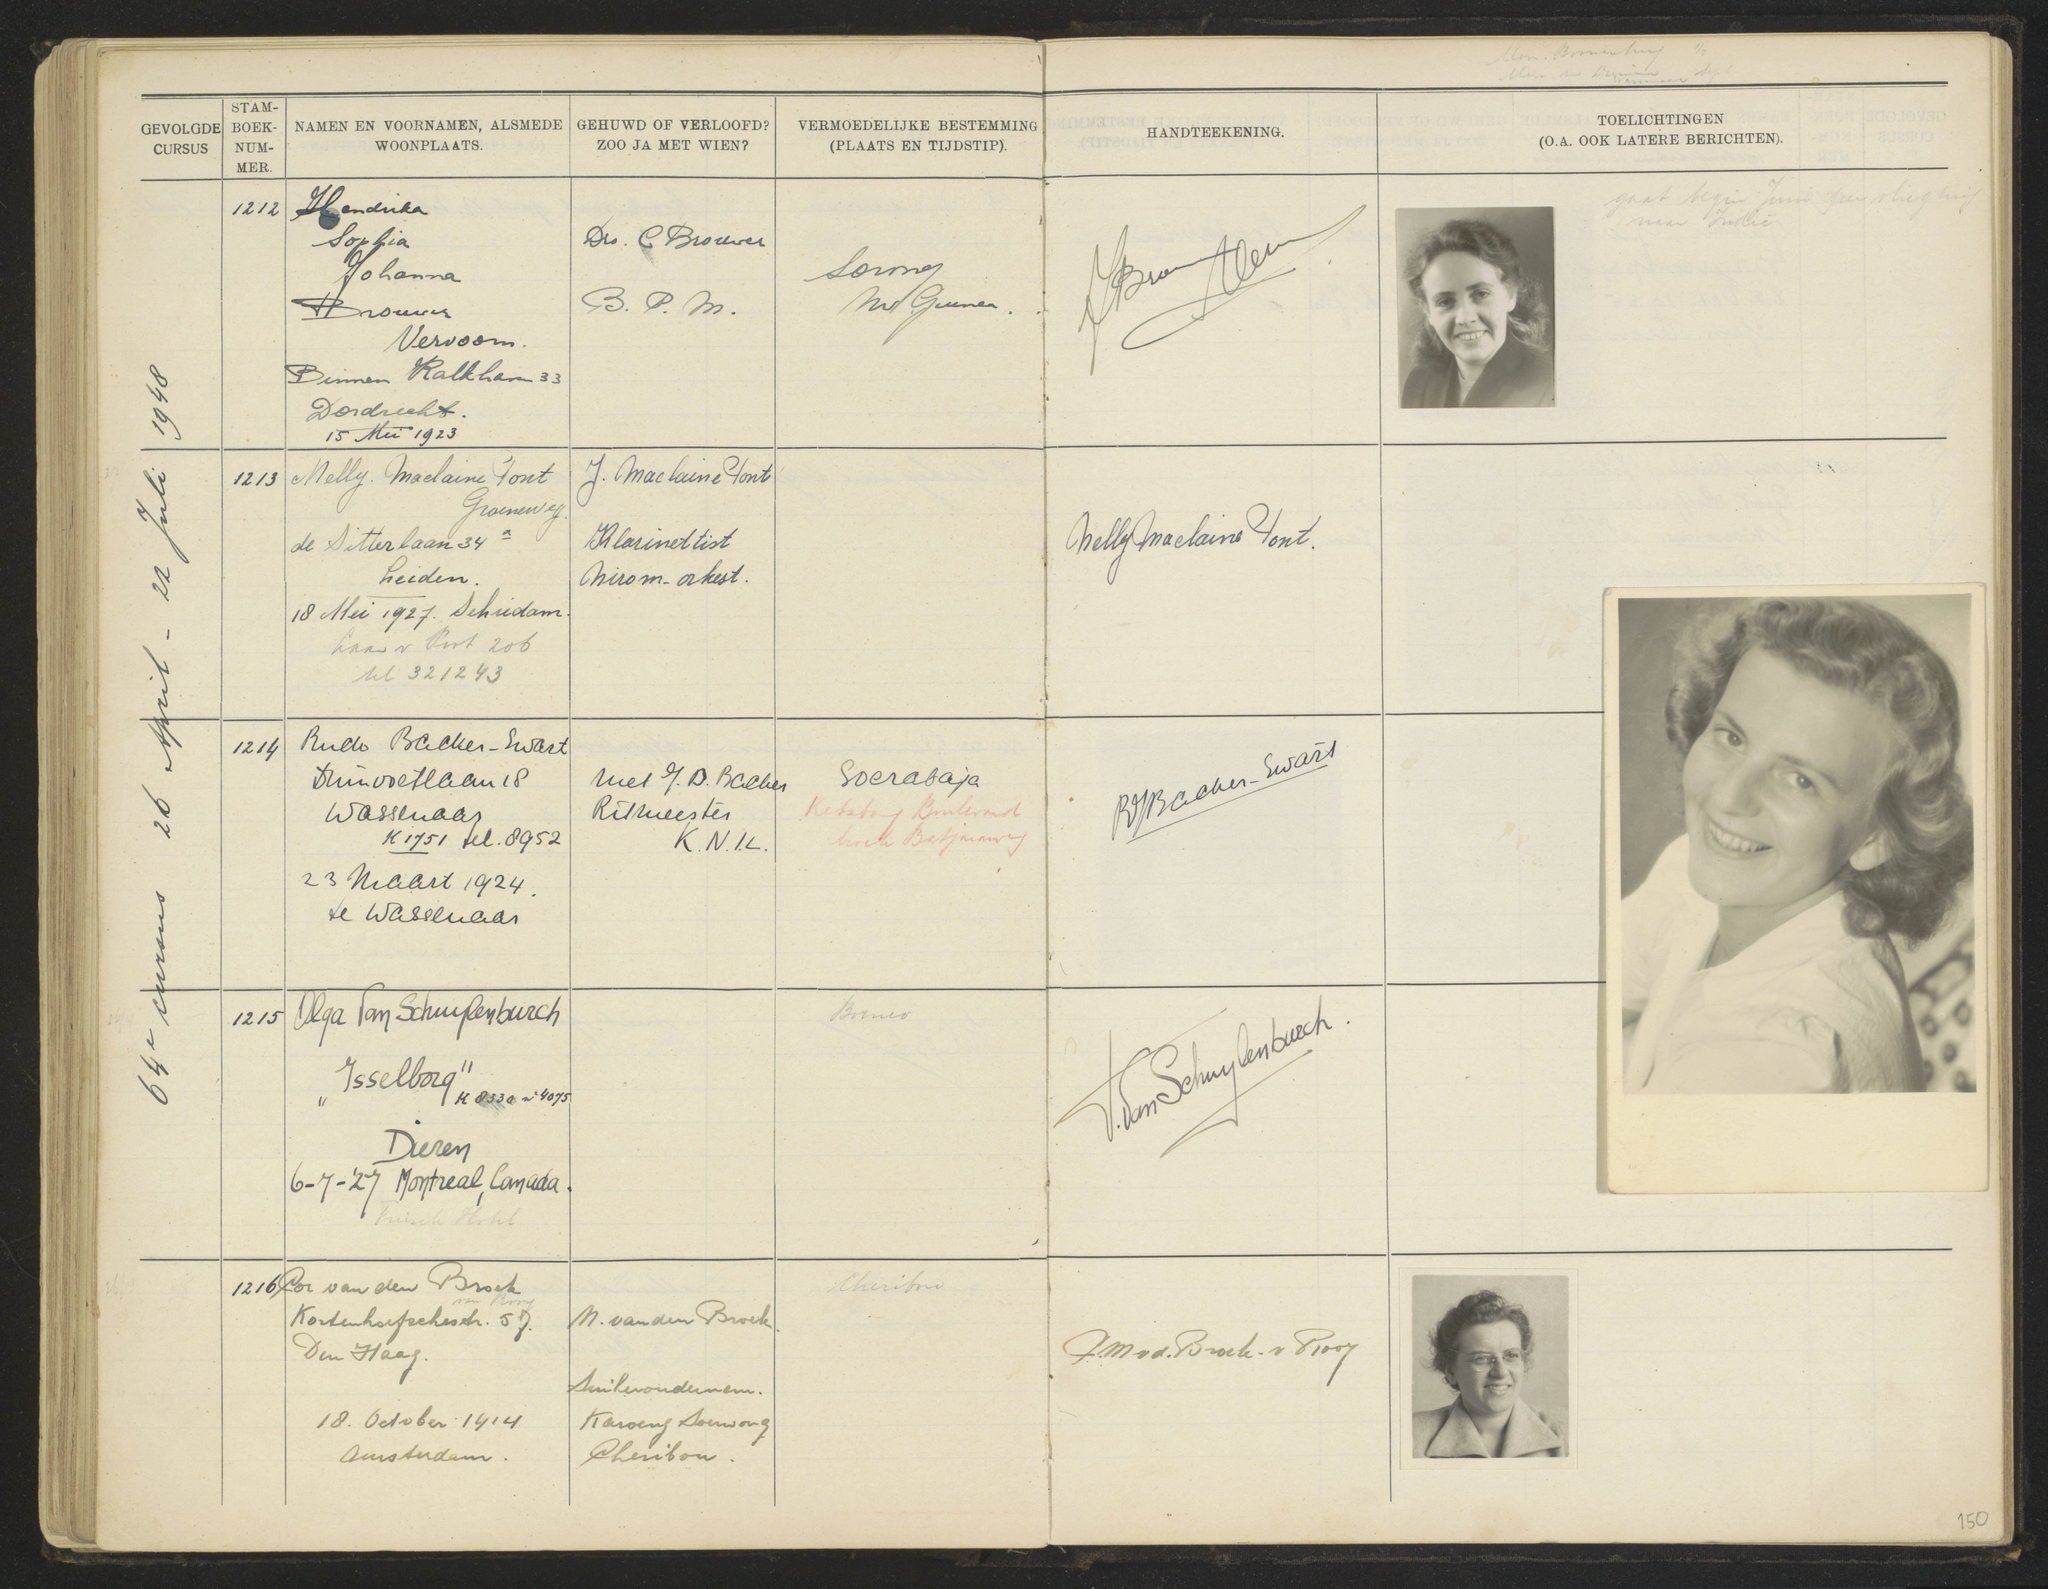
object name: album leaf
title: Blad 150 uit Stamboek van de leerlingen der Koloniale School voor Meisjes en Vrouwen te 's-Gravenhage deel II (1930-1949)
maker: Anonymous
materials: paper, photographic support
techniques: photography, printing, writing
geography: the hague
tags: further education (+ pupil), further education, the hague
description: Twee pagina's met gegevens van de deelnemers aan de 64e driemaandelijkse cursus van 26 april tot 22 juli 1948, stamboeknummers 1212 tot en met 1216. Onderdeel van Stamboek van de leerlingen der Koloniale School voor Meisjes en Vrouwen te 's-Gravenhage deel II (1930-1949).